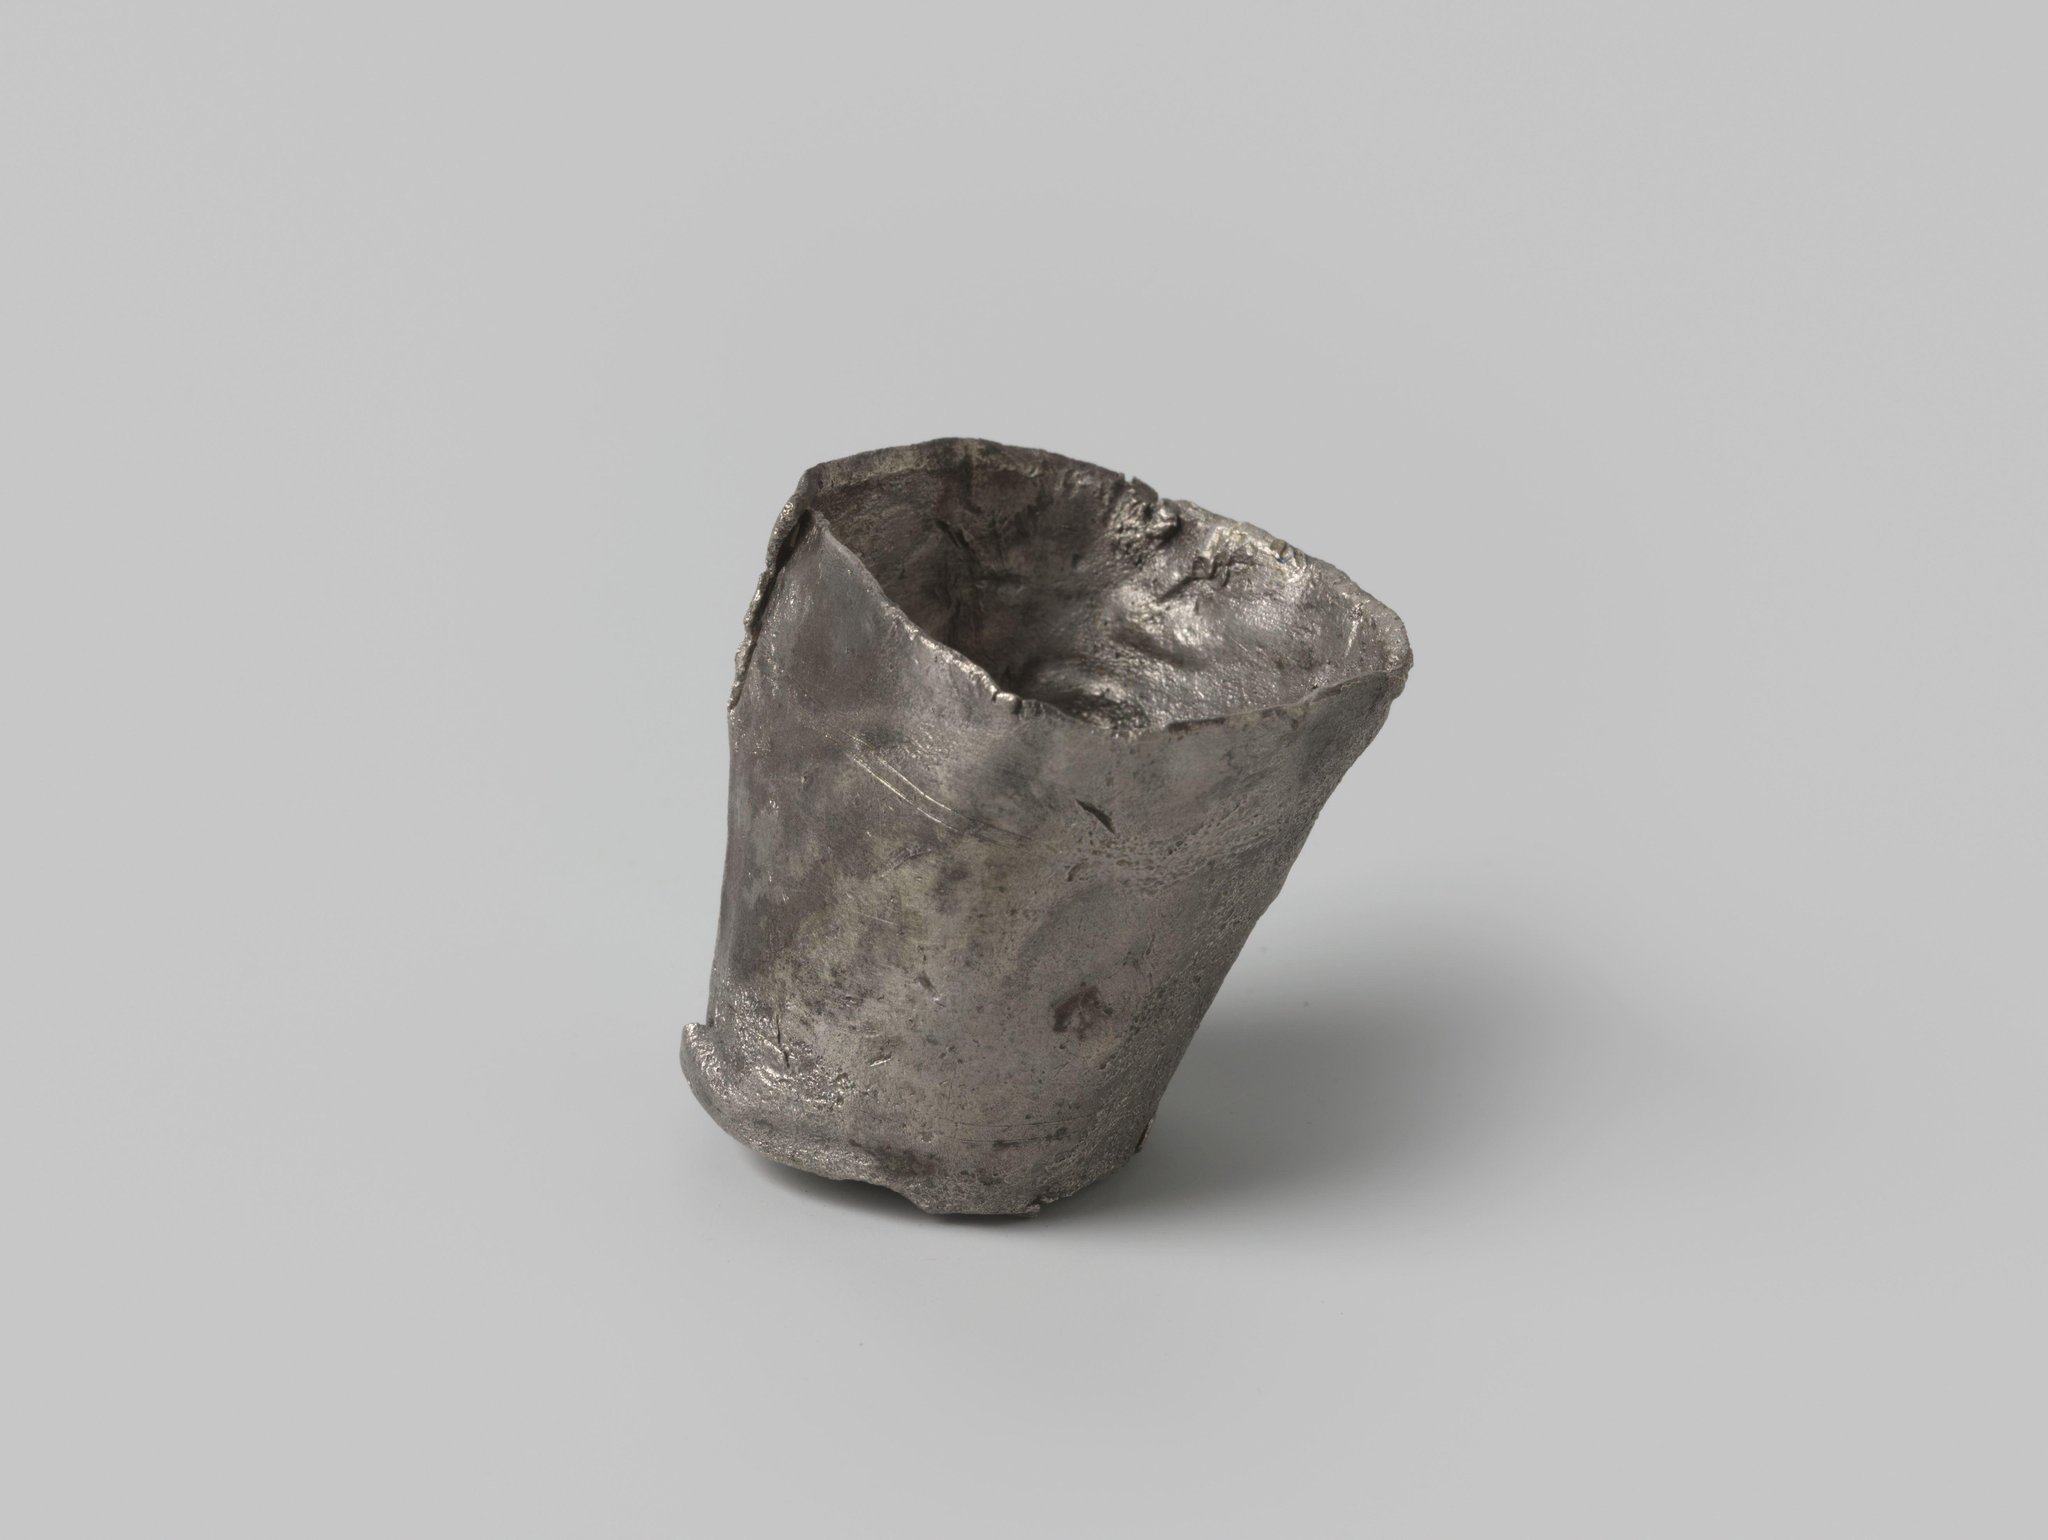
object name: cup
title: Beker uit het wrak van de Oost-Indiëvaarder Hollandia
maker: Anonymous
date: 1700-1743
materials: tin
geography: netherlands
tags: verenigde oostindische compagnie, hollandia (schip), annet